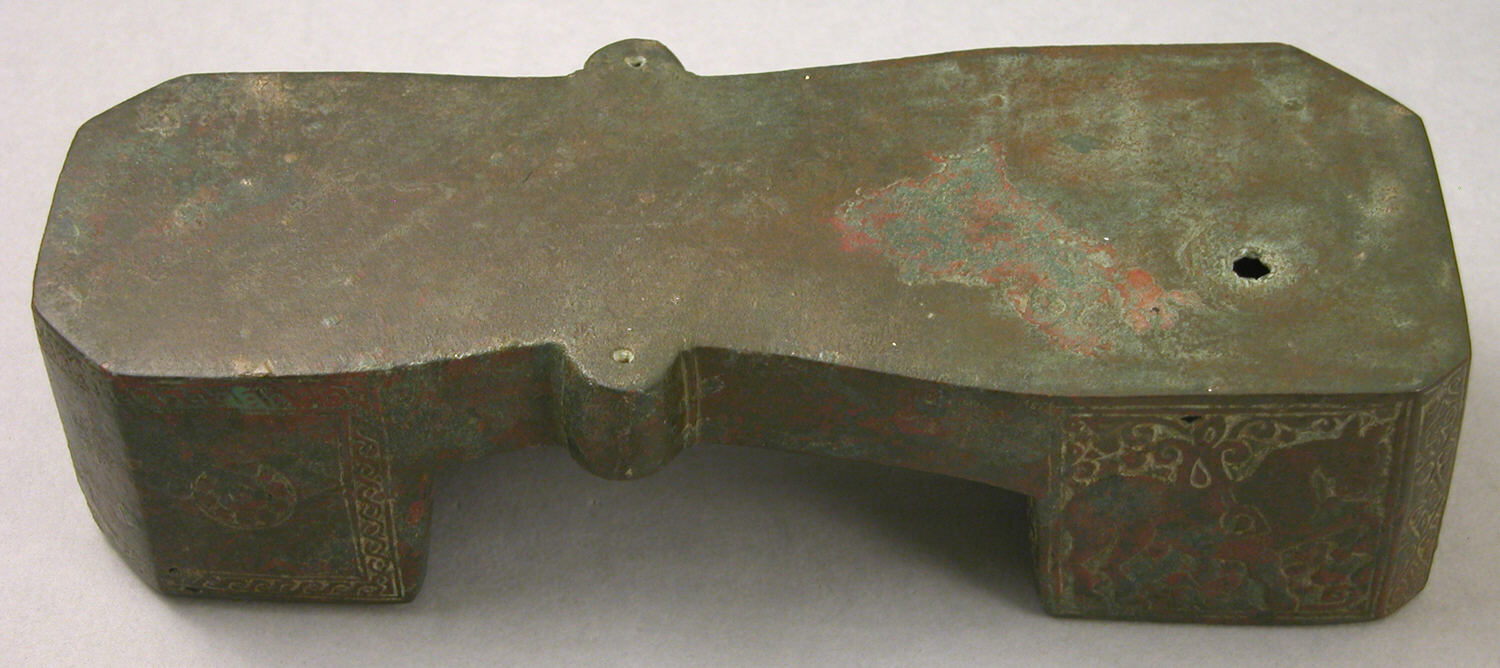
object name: clog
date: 1101-1200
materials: bronze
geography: iran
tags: footwear